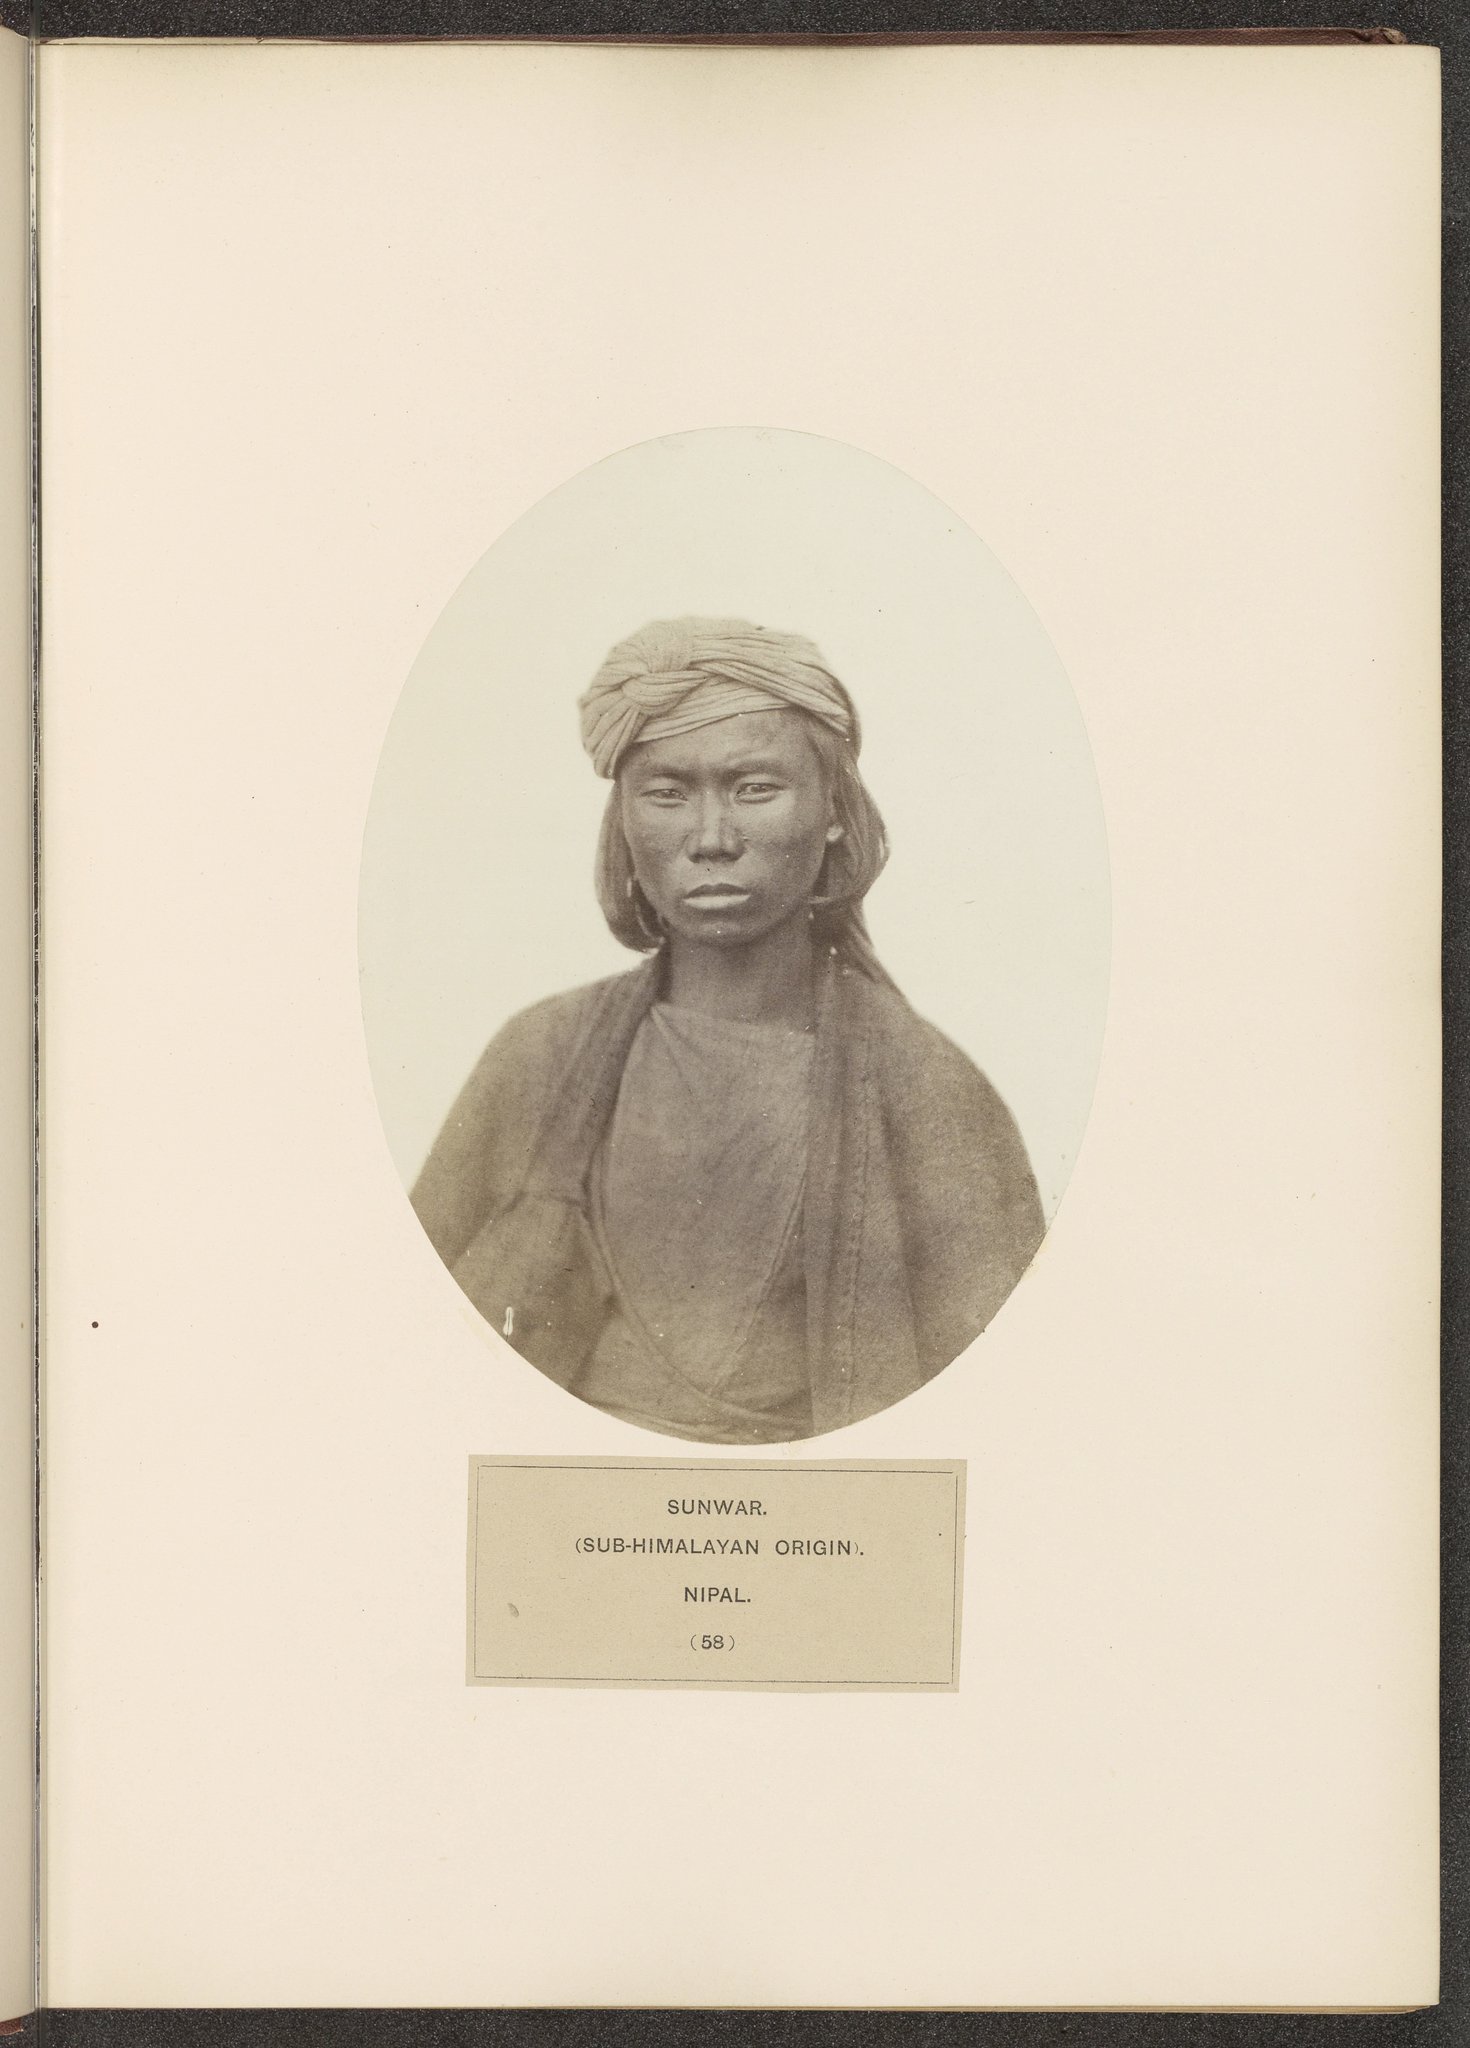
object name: photograph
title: Portrait of an unknown man from the Sunuwar tribe of Nepal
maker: Anonymous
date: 1858-1868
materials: photographic support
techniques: albumen print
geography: nepal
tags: head-gear: turban, human races; peoples; nationalities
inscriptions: inscription: ‘SUNWAR./ (SUB-HIMALAYAN ORIGIN)./ NIPAL.’, number: ‘(58)’